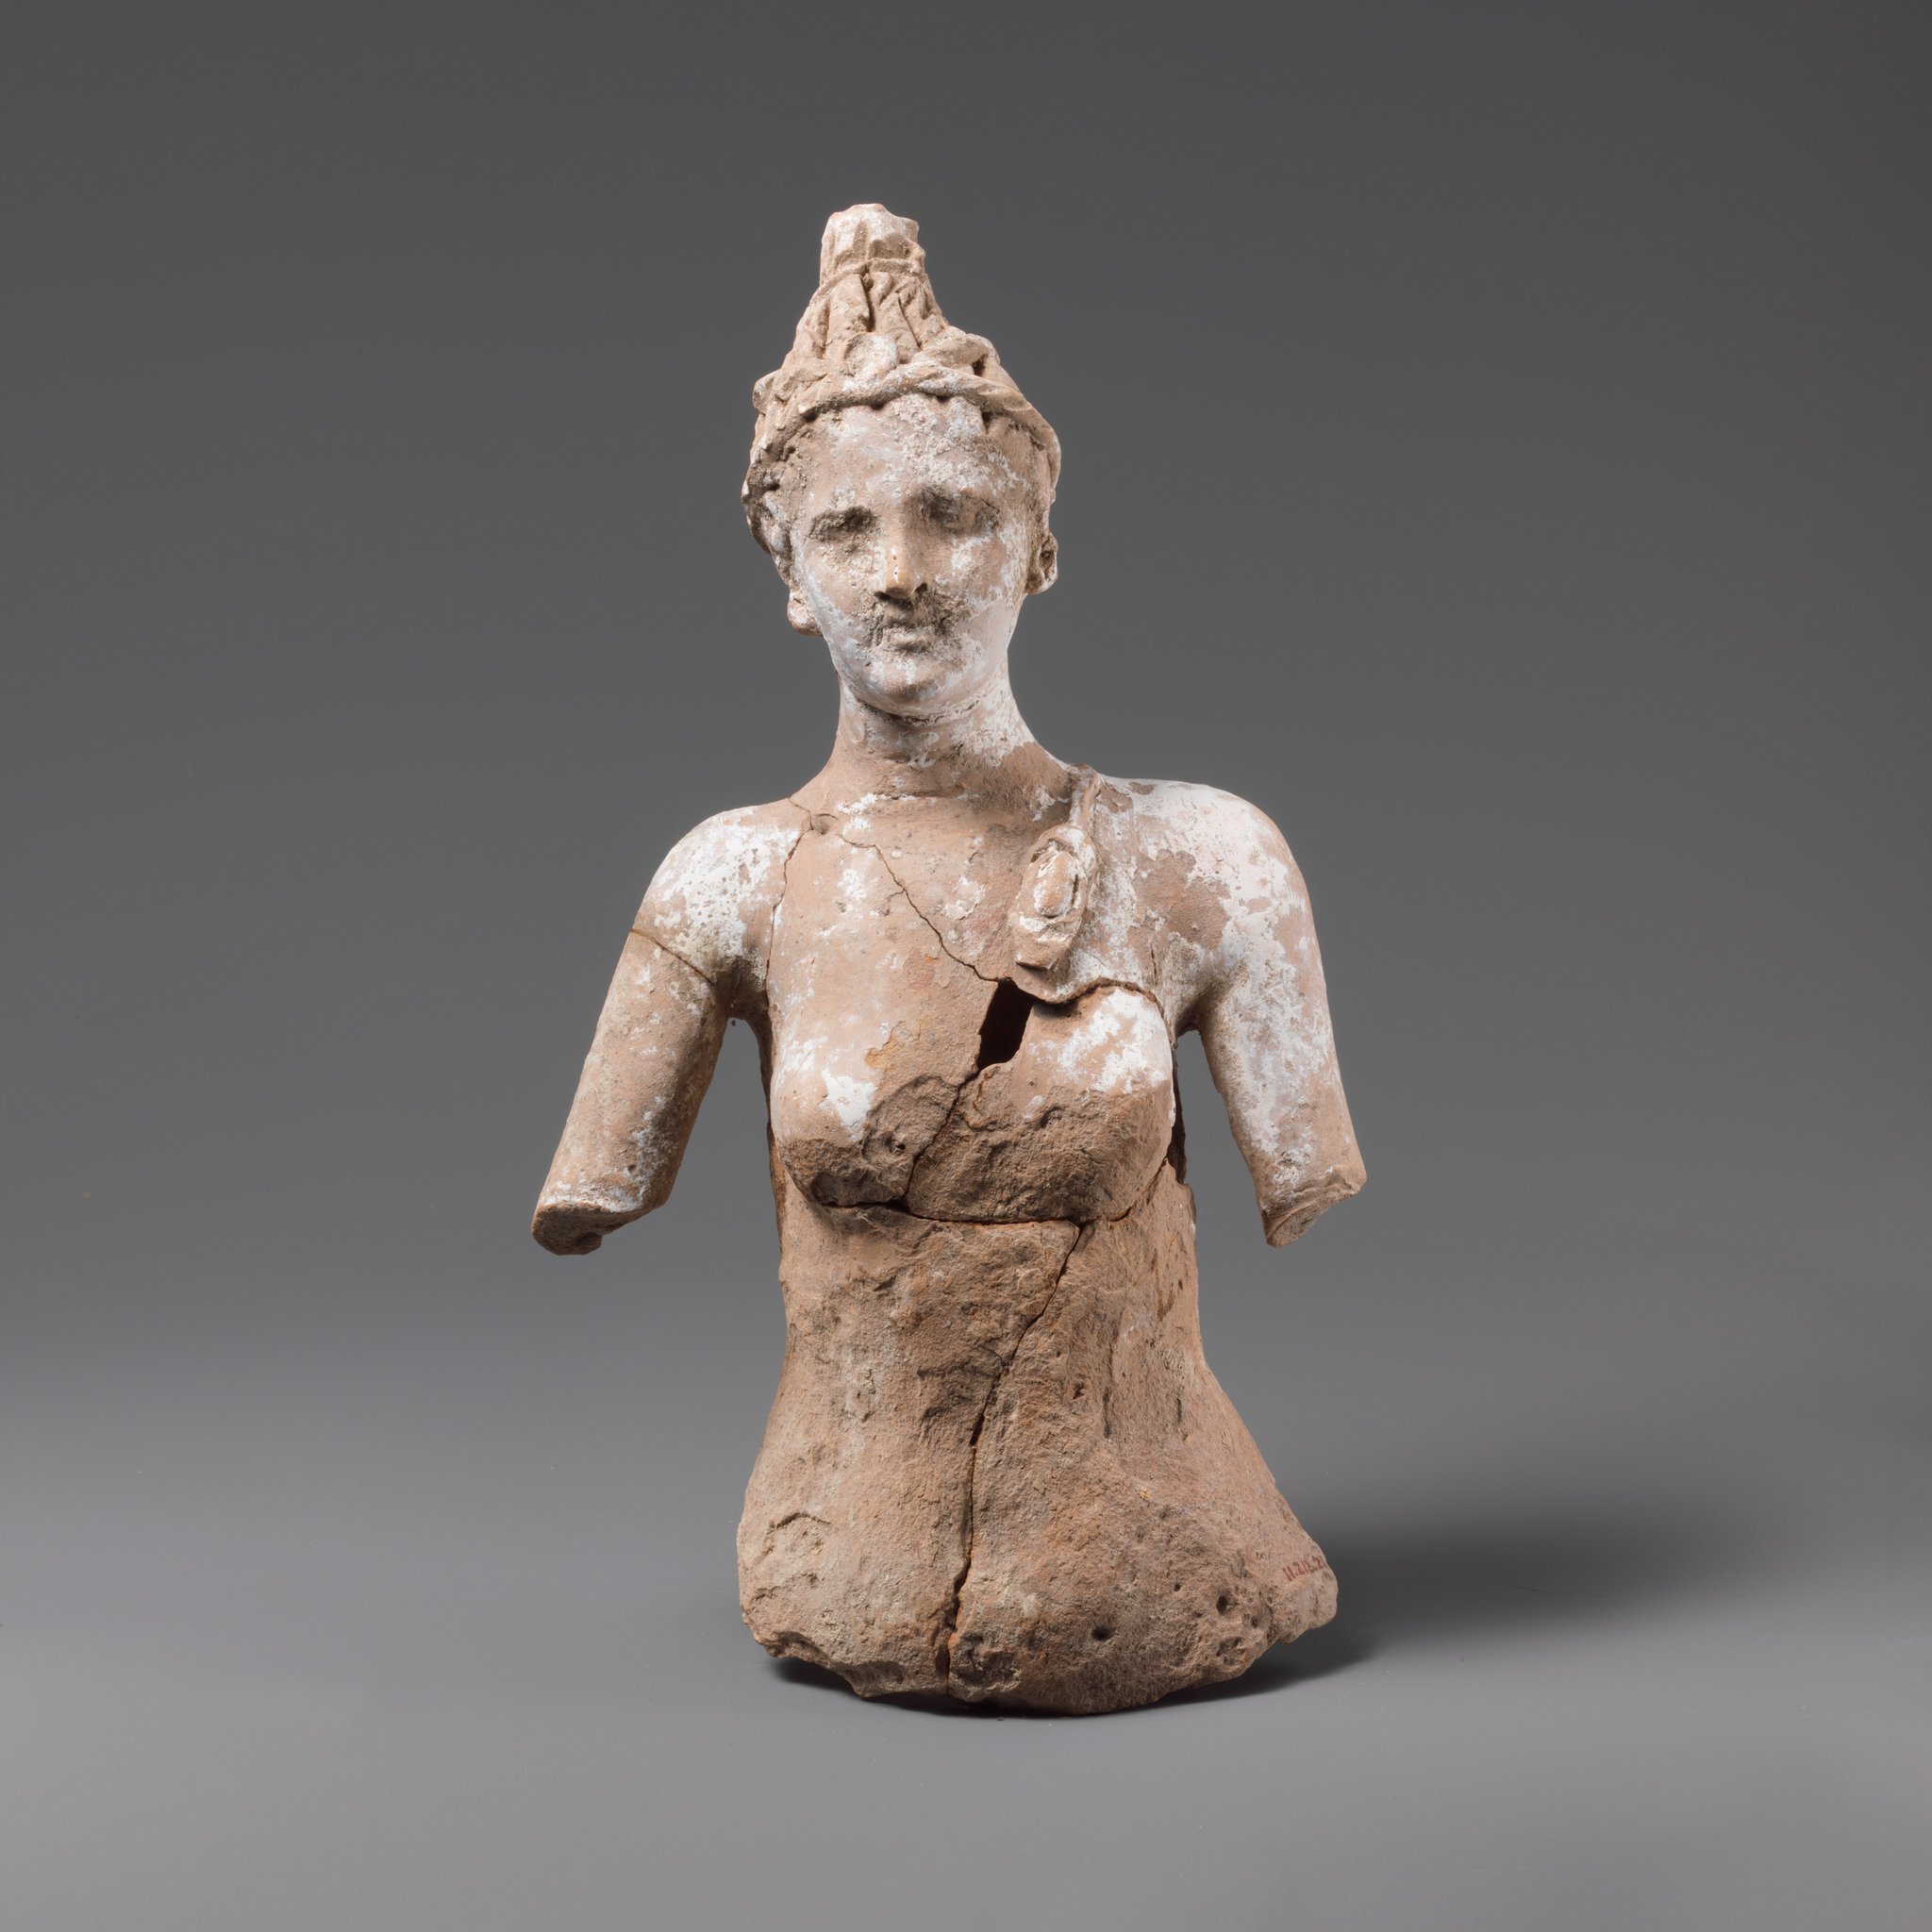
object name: statuette of a woman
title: Fragmentary terracotta female statuette, perhaps Artemis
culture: greek, south italian, tarentine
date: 300-101 BCE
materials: terracotta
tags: artemis